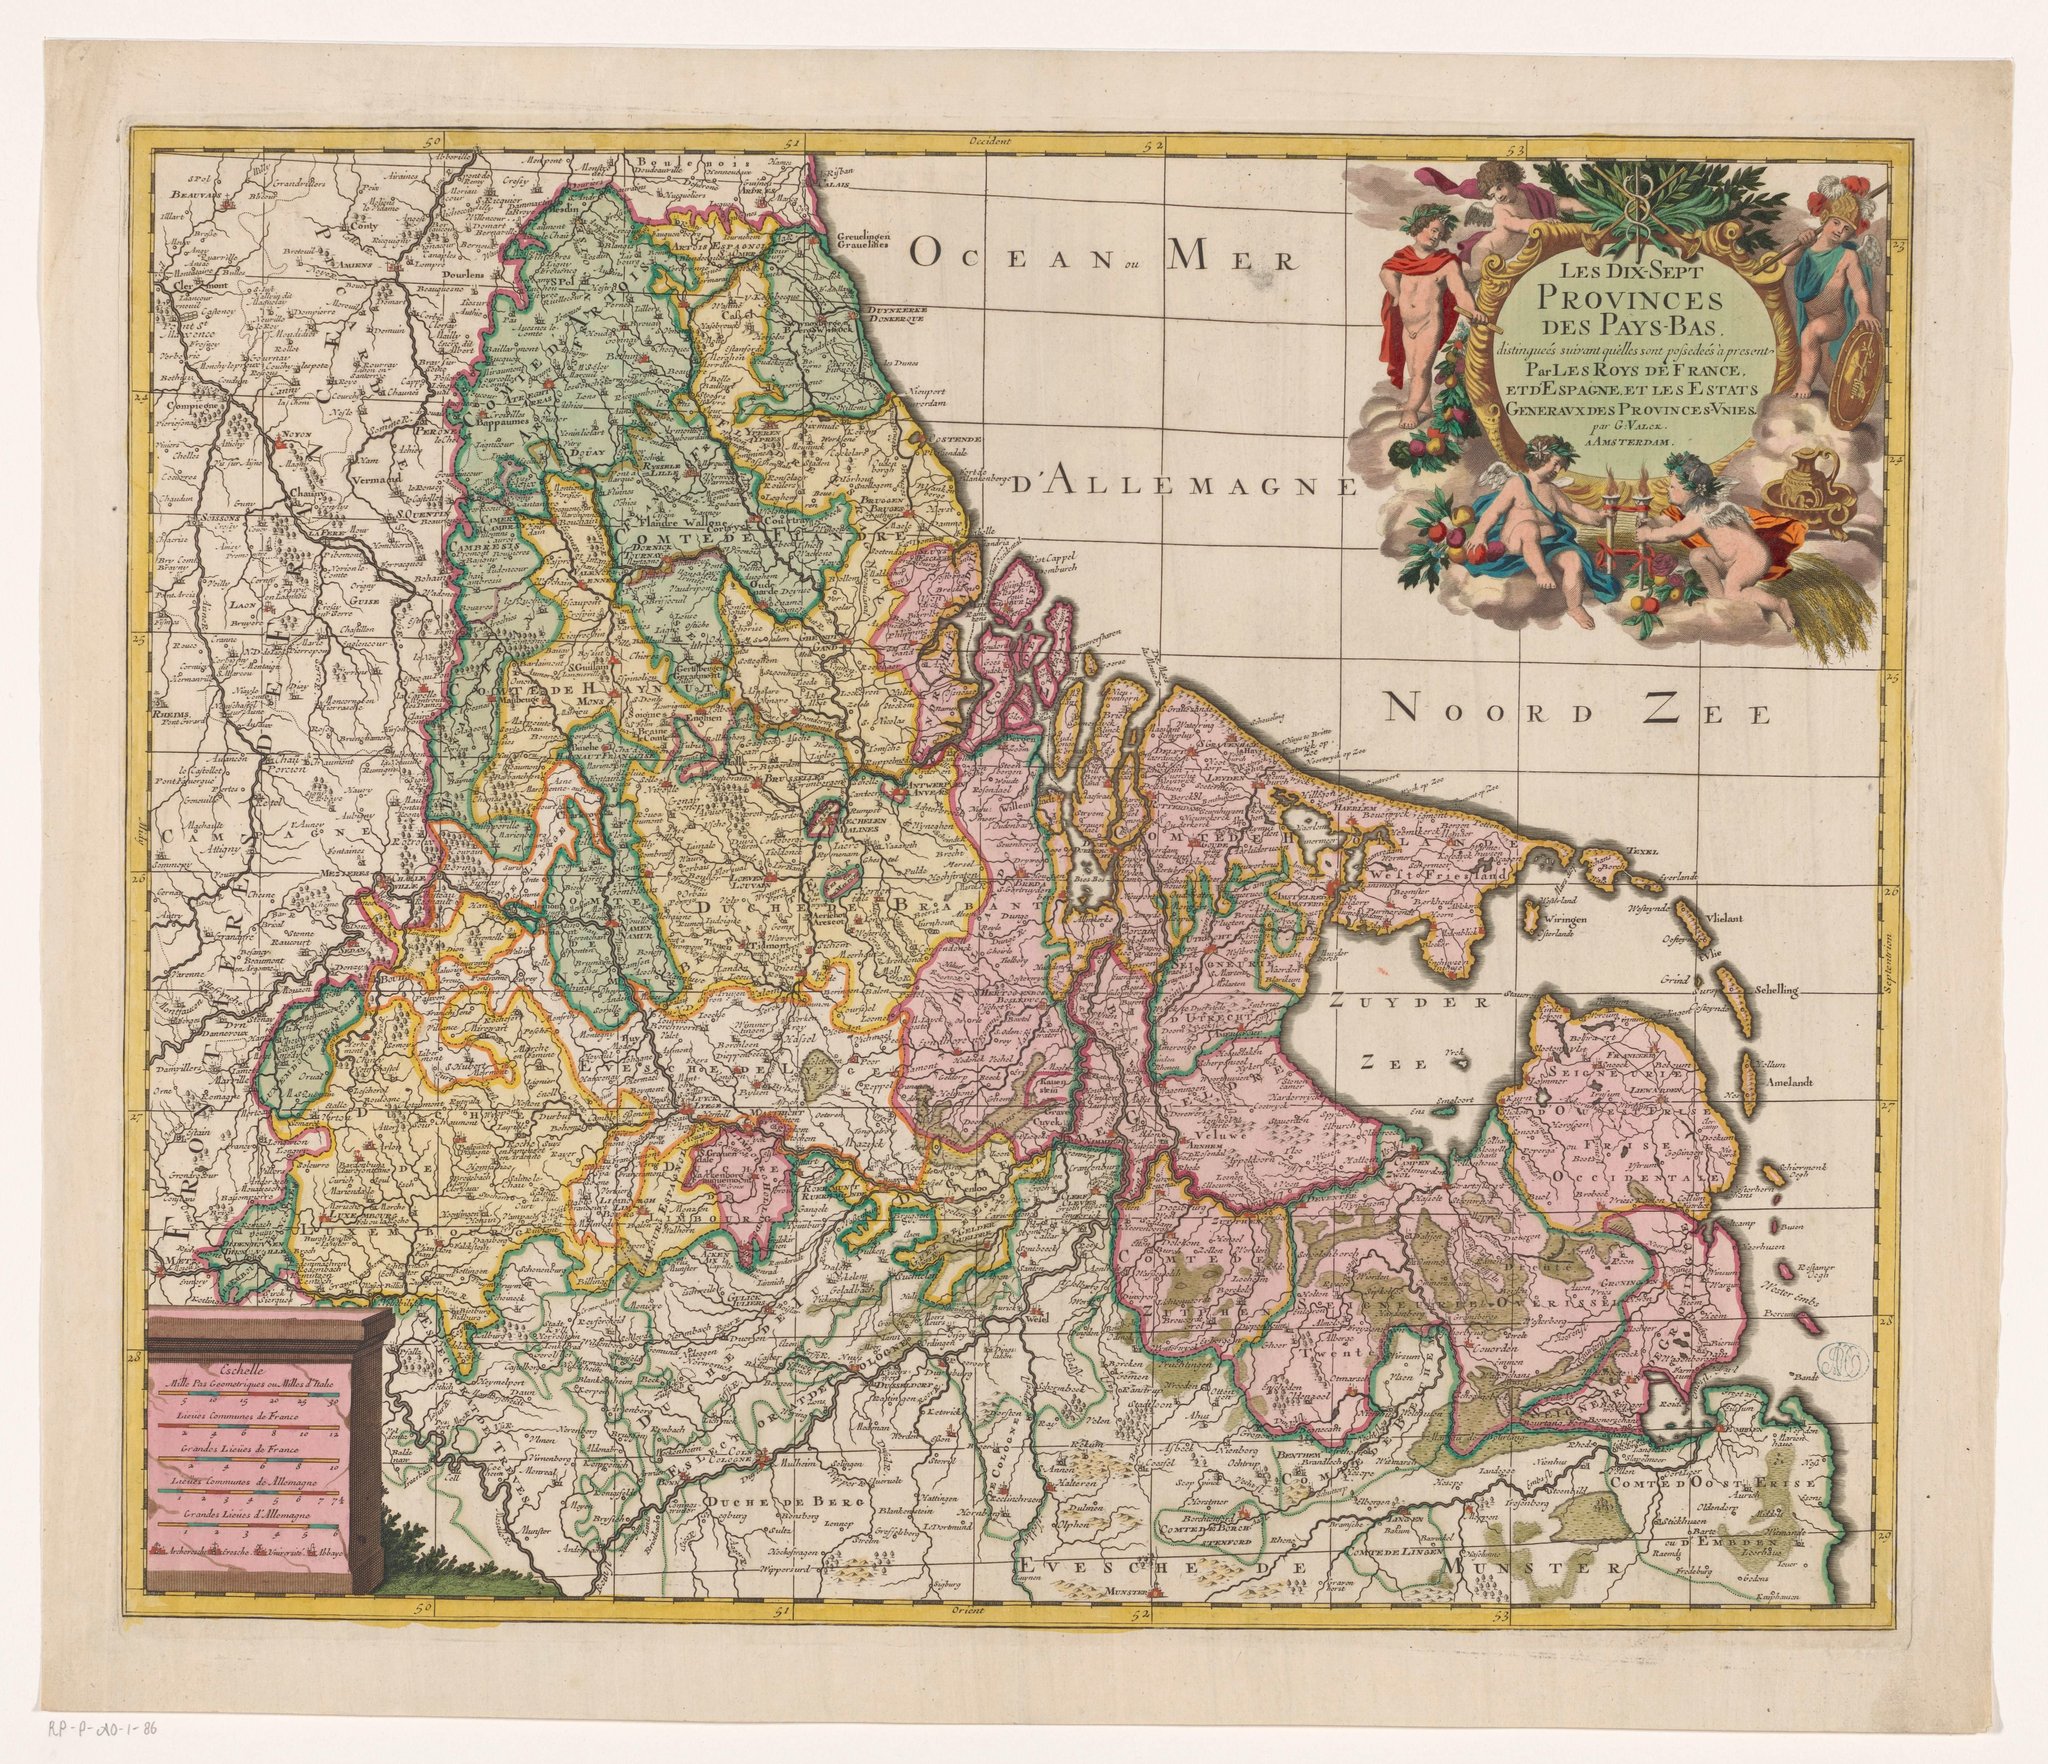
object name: map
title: Les dix-sept provinces des Pays-Bas (...)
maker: gerard valck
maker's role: print maker, publisher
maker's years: 1651-1726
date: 1700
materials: paper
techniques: engraving, etching, hand coloring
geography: amsterdam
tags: maps of separate countries or regions, low countries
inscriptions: collector's mark: Lugt 2228, collector's mark: Lugt 195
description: Rechts titelcartouche met daaromheen een aantal putti. Linksonder legenda en schaalstok: Mille pas geometriques ou milles d'Italie, Lieües communes de France, en nog drie andere. De kaart is voorzien van een coördinaten-net en een gradenverdeling langs de randen. Oriëntatie: noorden rechts.